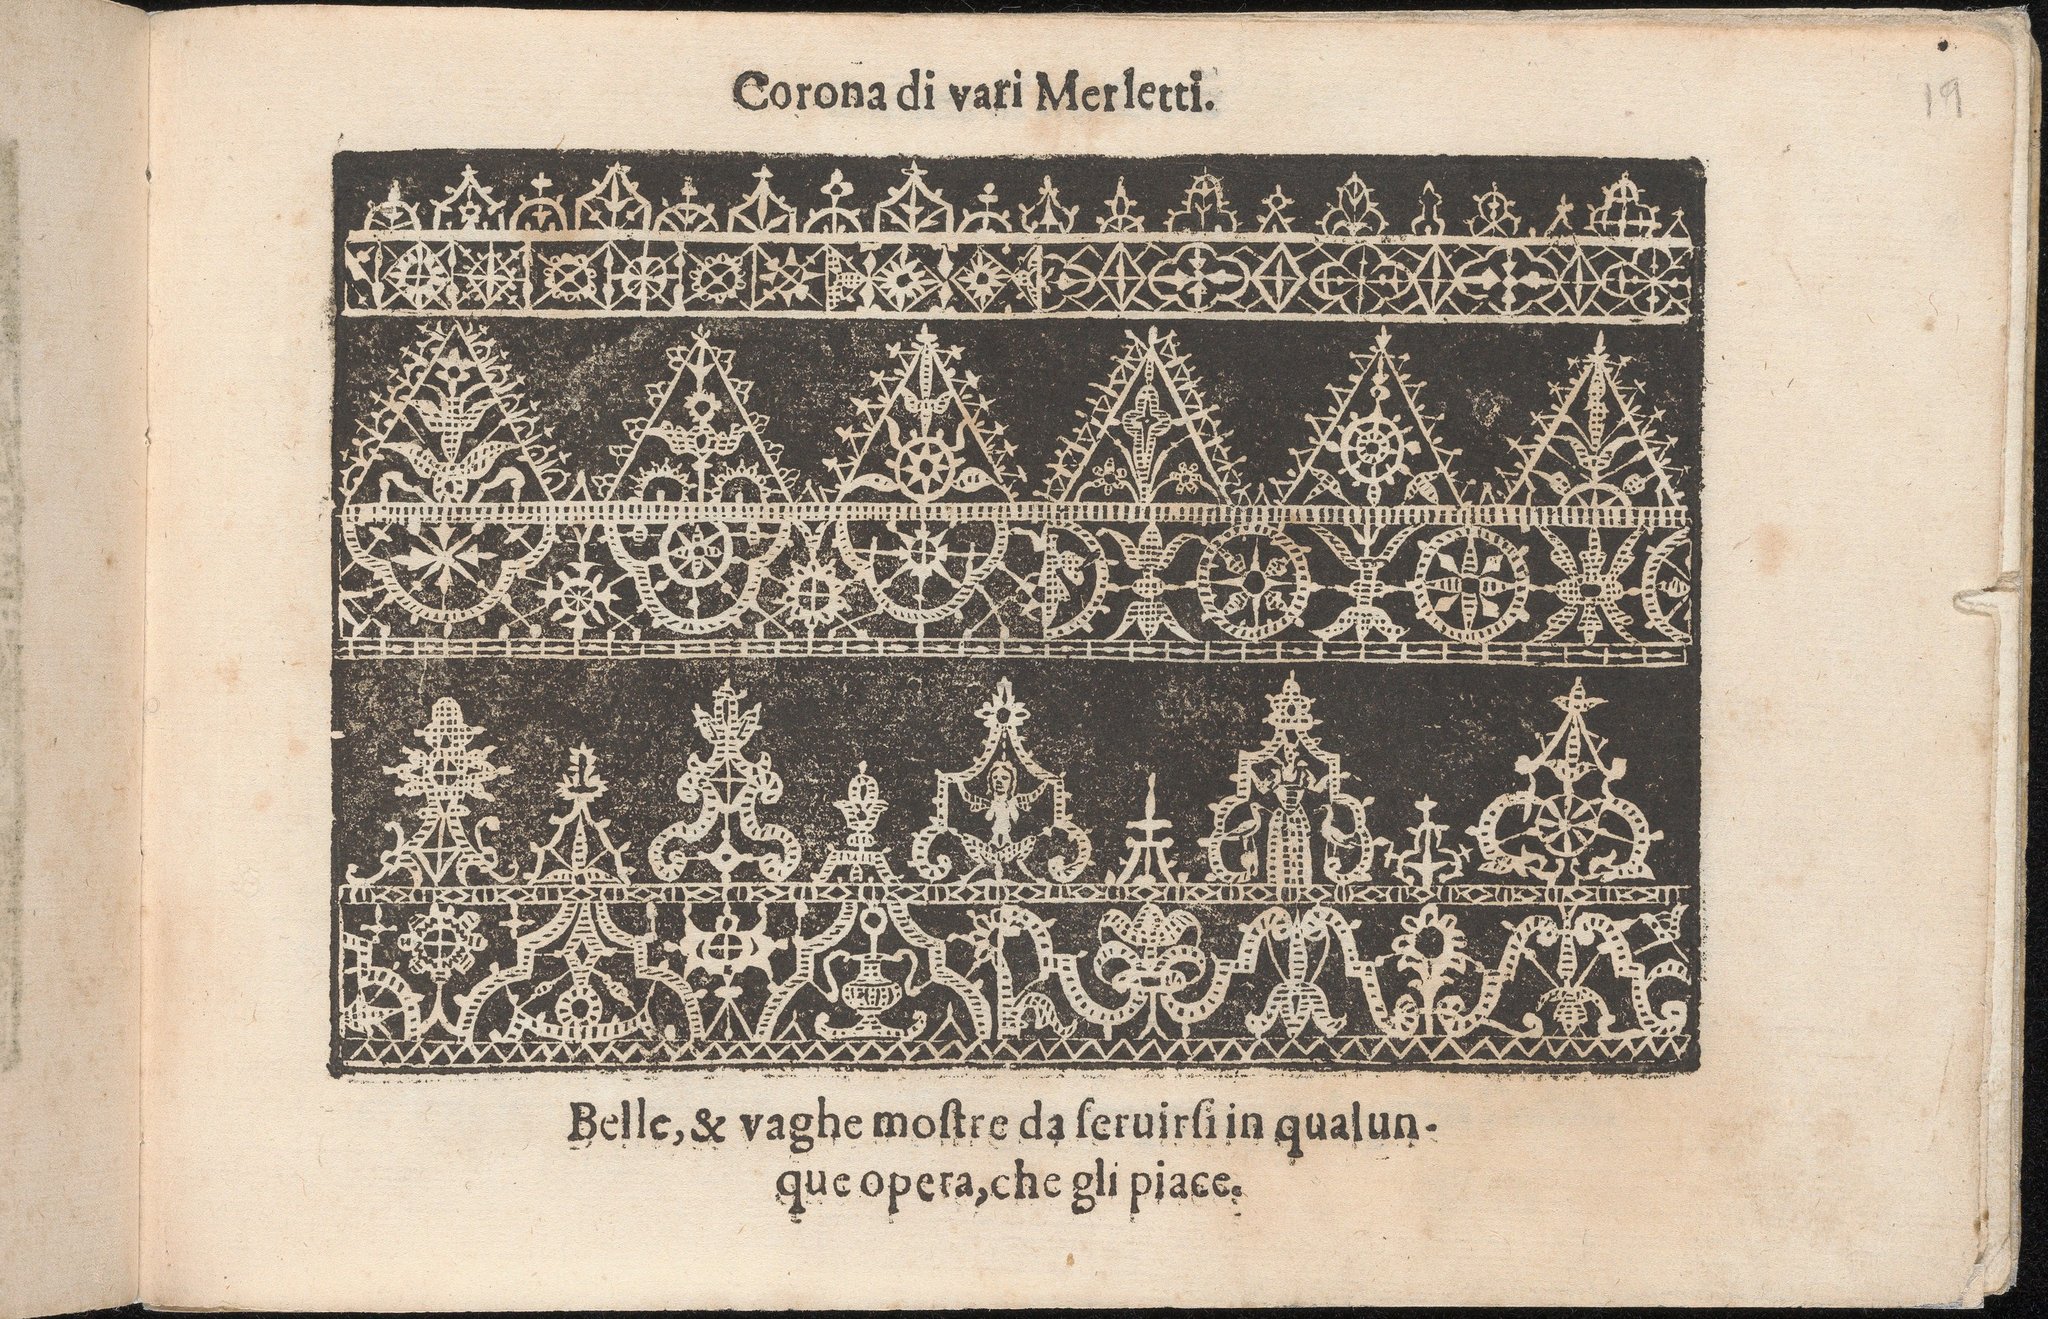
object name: book print ornament architecture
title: Corona delle Nobile et Virtuose Donne, Libro Terzo, page 19 (recto)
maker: cesare vecellio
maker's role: designer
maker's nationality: italian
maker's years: 1521-1601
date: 1620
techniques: woodcut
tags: ornament